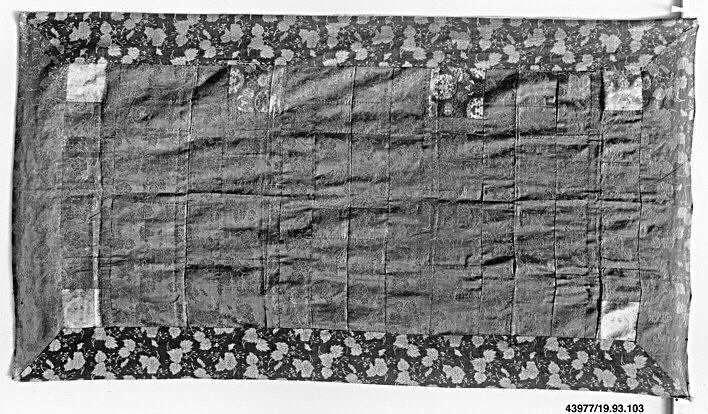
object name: robe, priest's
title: Priest's Robe (Shichijō)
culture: japanese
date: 1625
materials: metal thread, silk